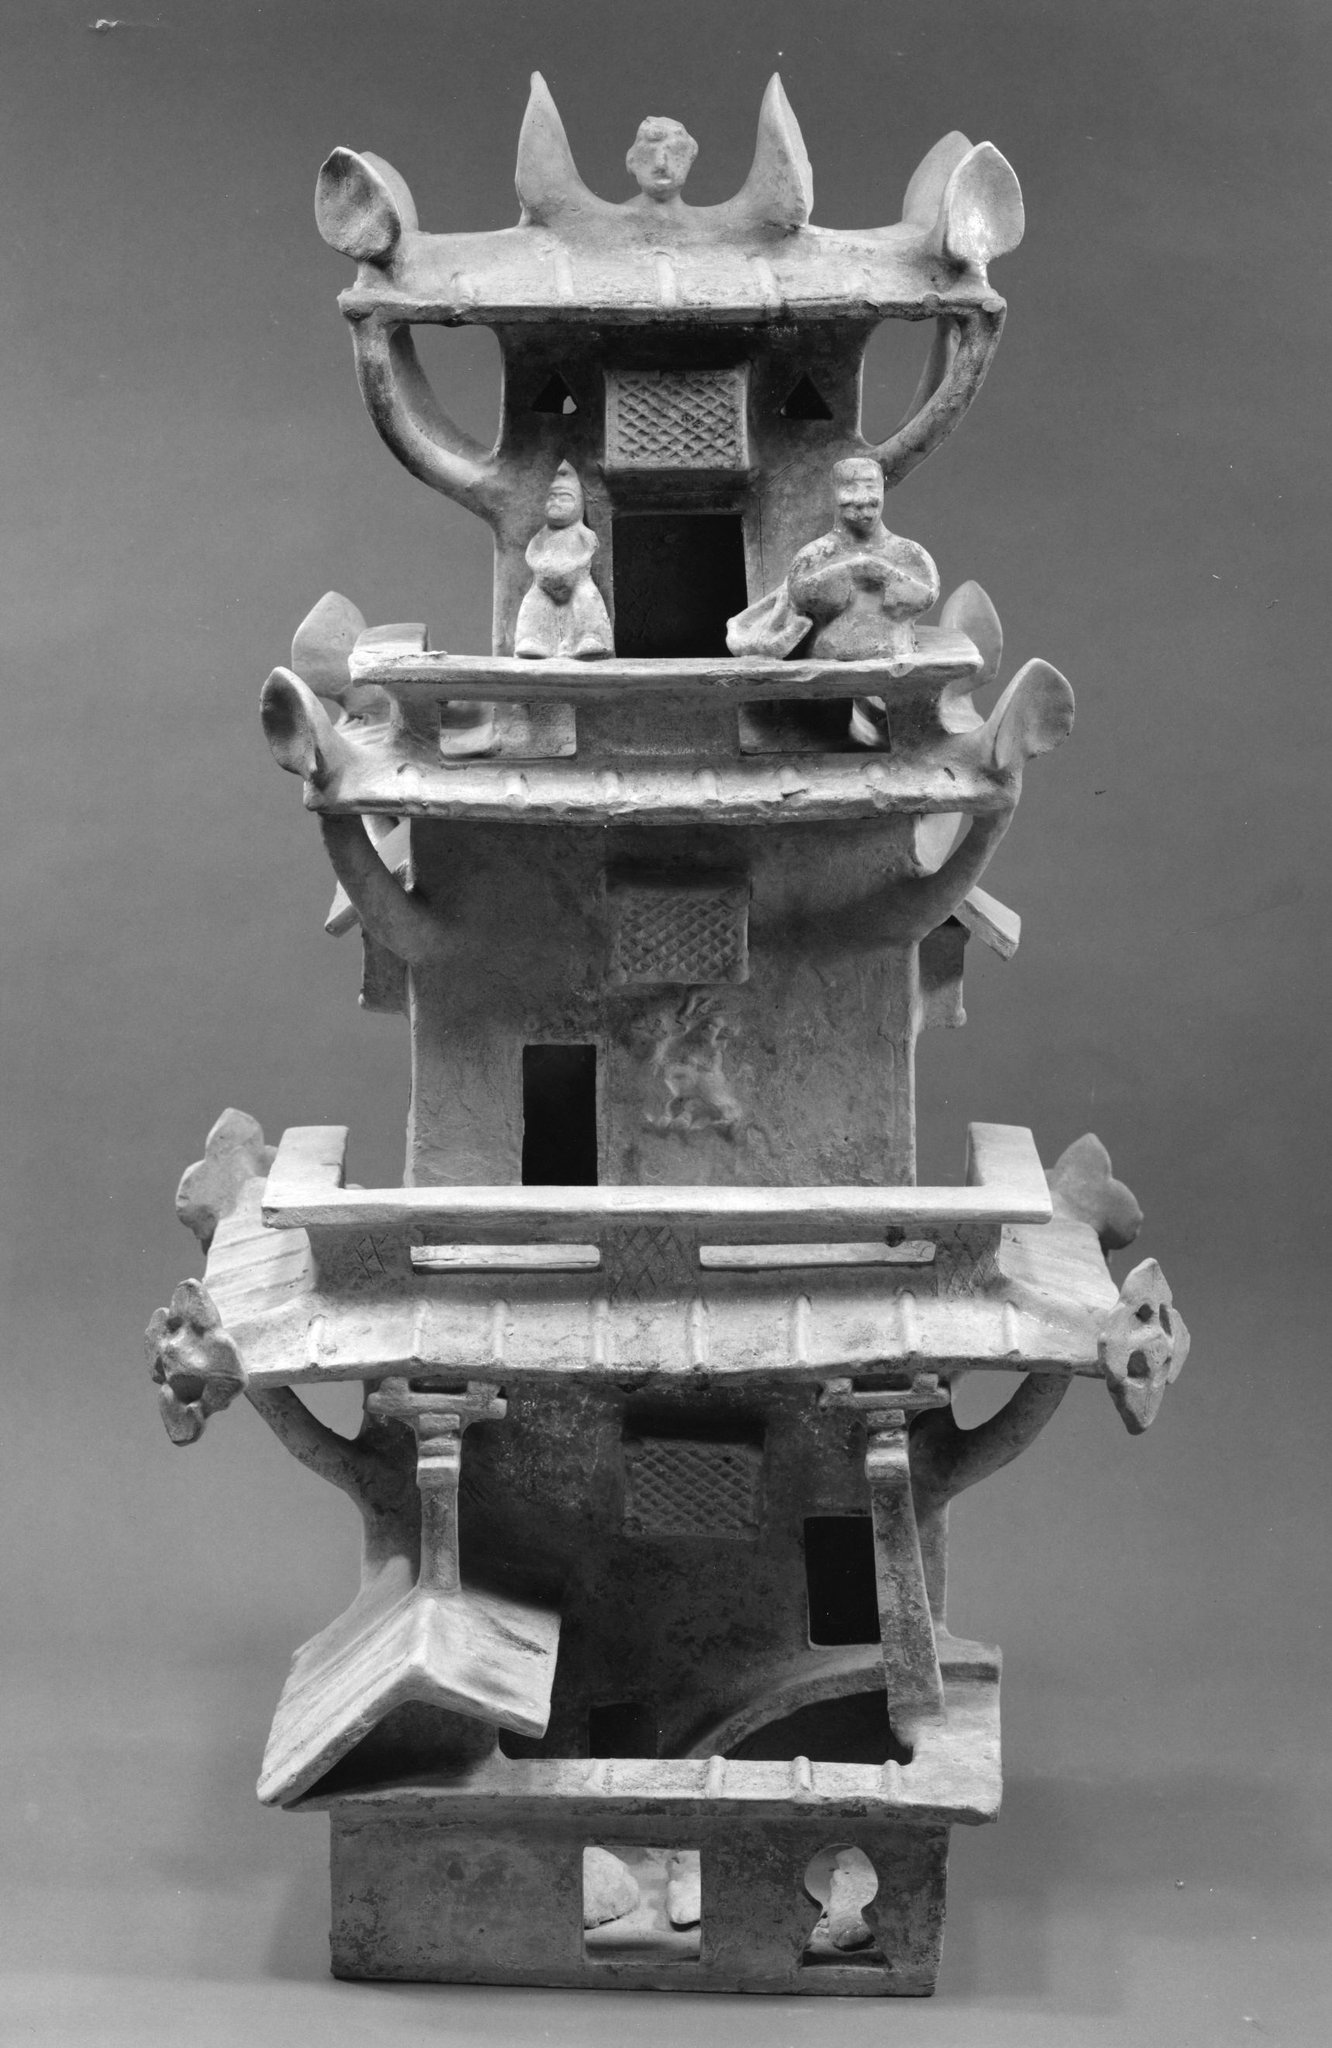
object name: architectural model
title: Multistoried Watchtower with Front Court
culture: chinese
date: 1-233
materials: earthenware, glaze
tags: towers